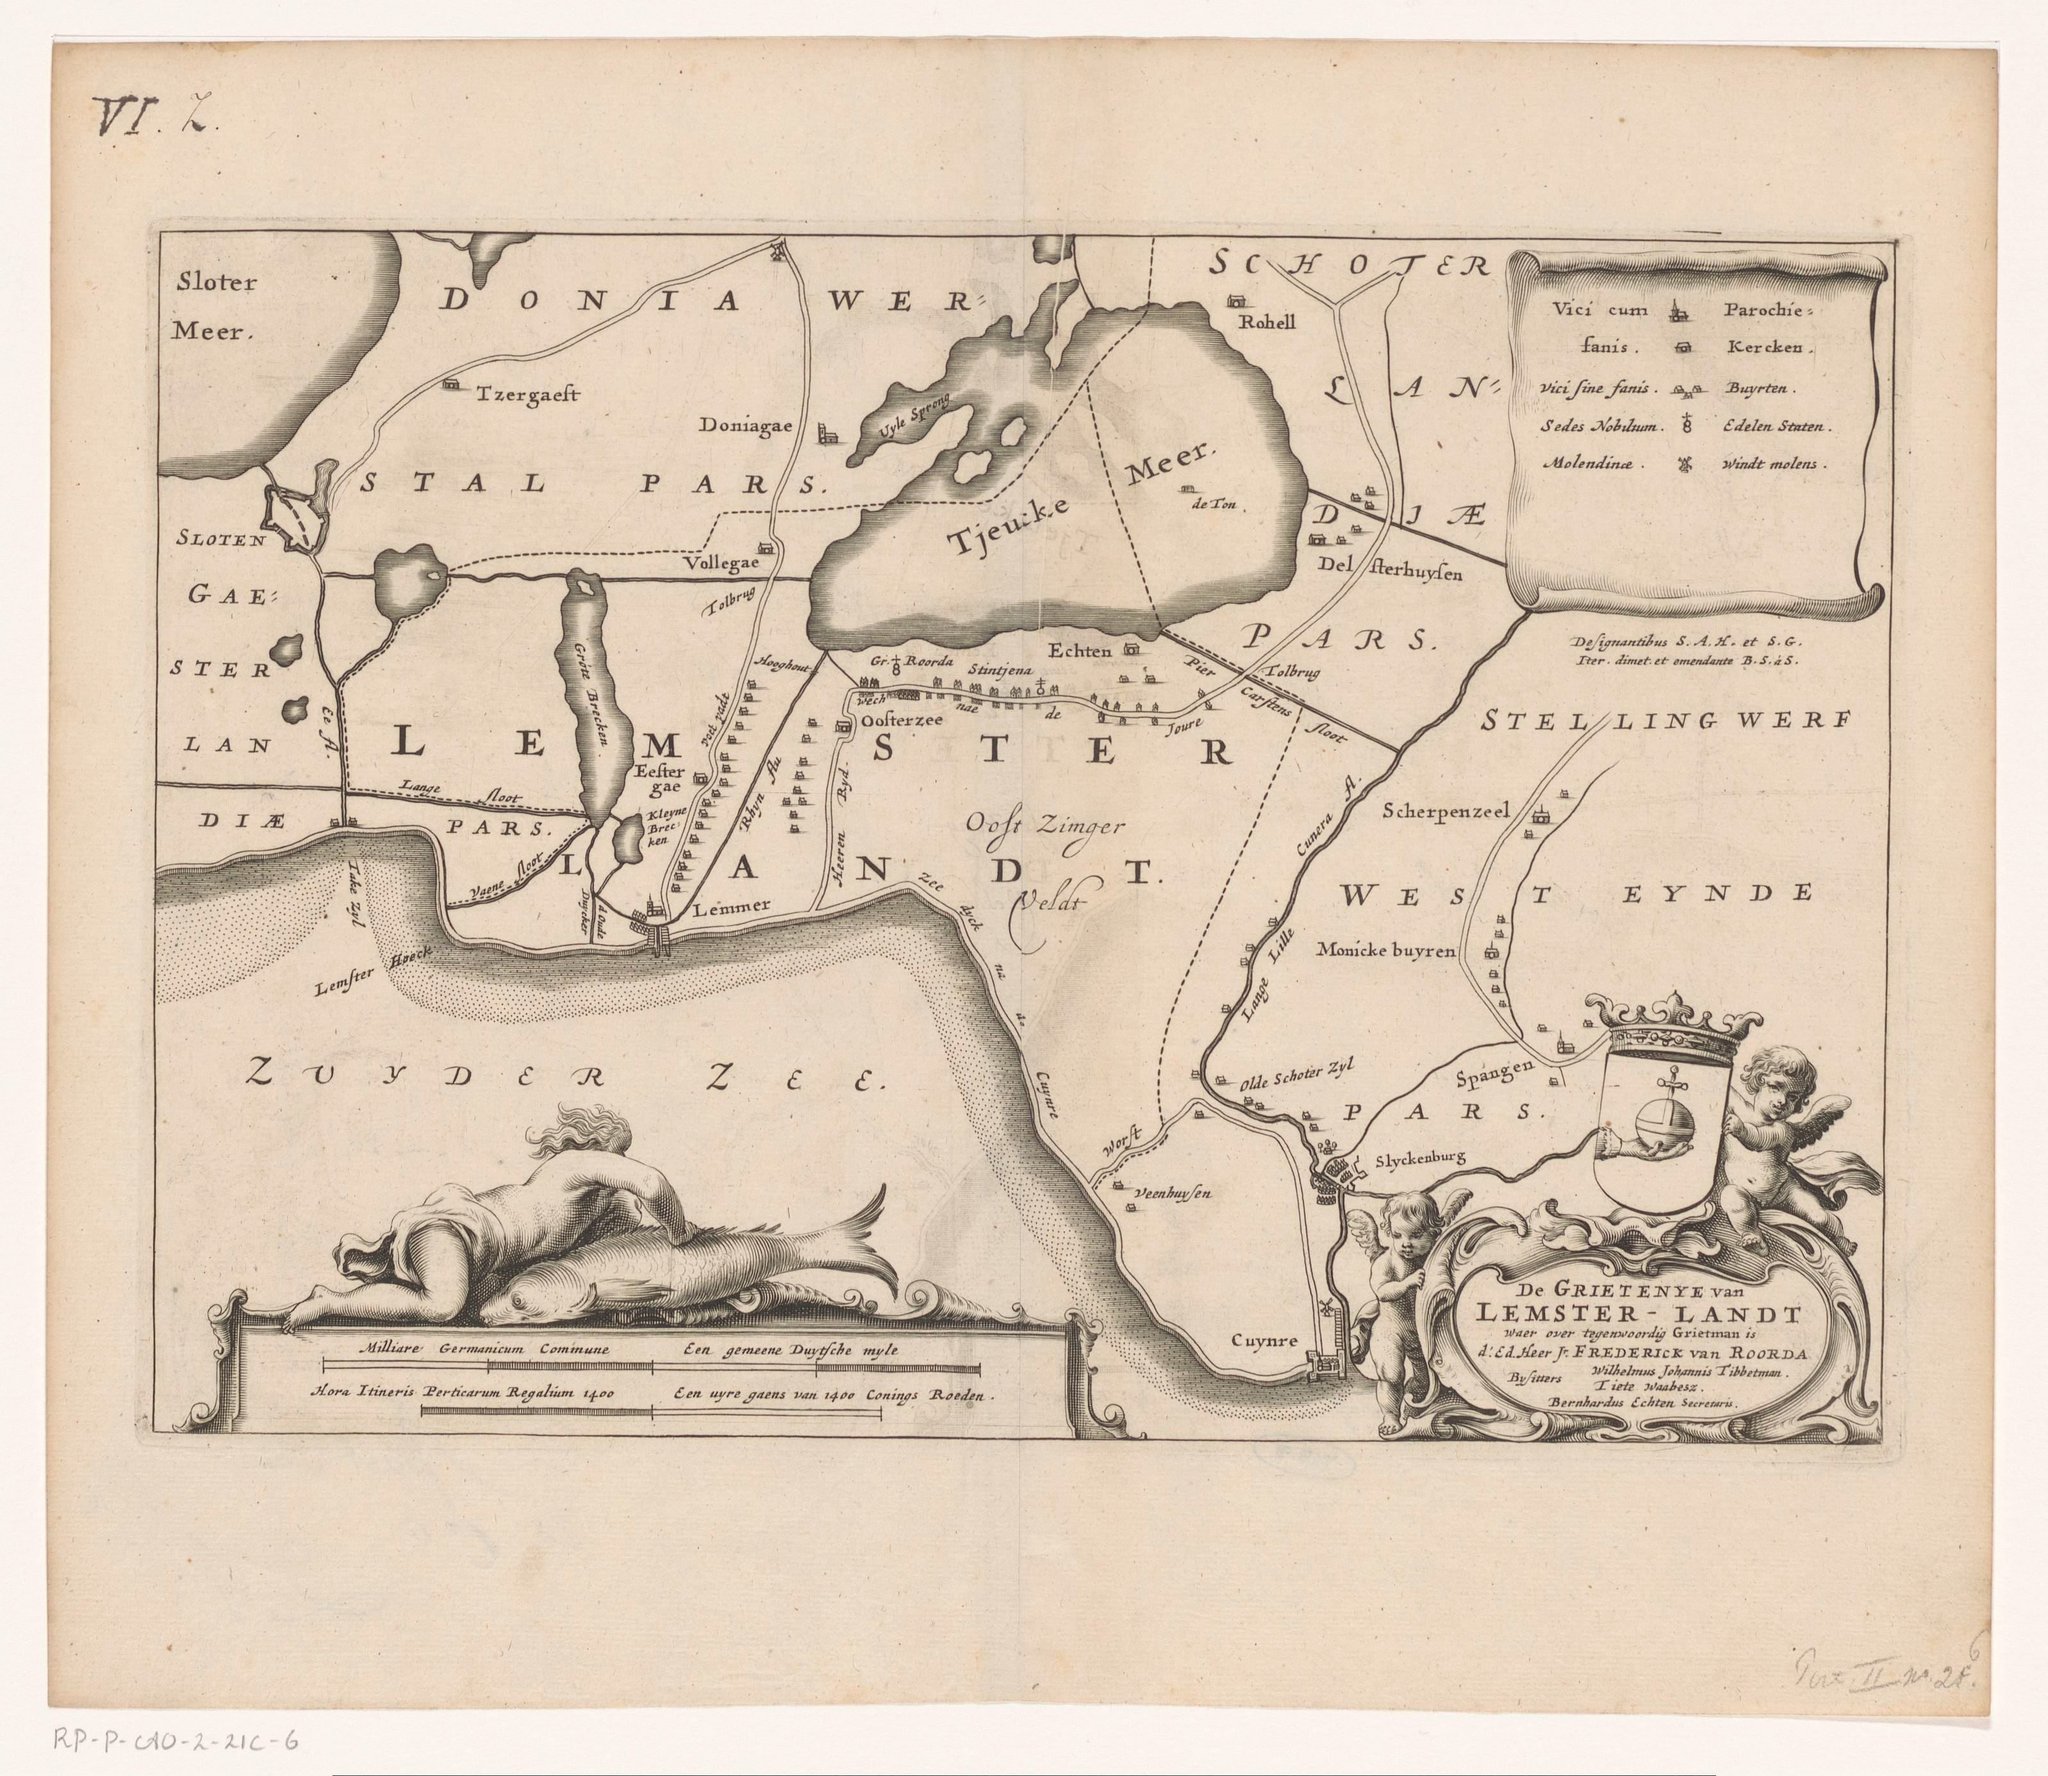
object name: print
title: Kaart van de grietenij Lemsterland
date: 1664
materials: paper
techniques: engraving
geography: friesland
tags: coat of arms (as symbol of the state, etc.), maps of separate countries or regions, fishes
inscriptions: collector's mark: Lugt 2228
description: Linksonder twee schaalstokken: Milliare Germanicum commune / Een gemeene Duytsche myle, Hora itineris perticarum regalium 1400 / Een uyre gaens van 1400 conings roeden. Daaromheen een man met een vis. Rechtsboven legenda. Rechtsonder cartouche met het wapen van Lemsterland, titel en bestuurlijke informatie over de grietenij.